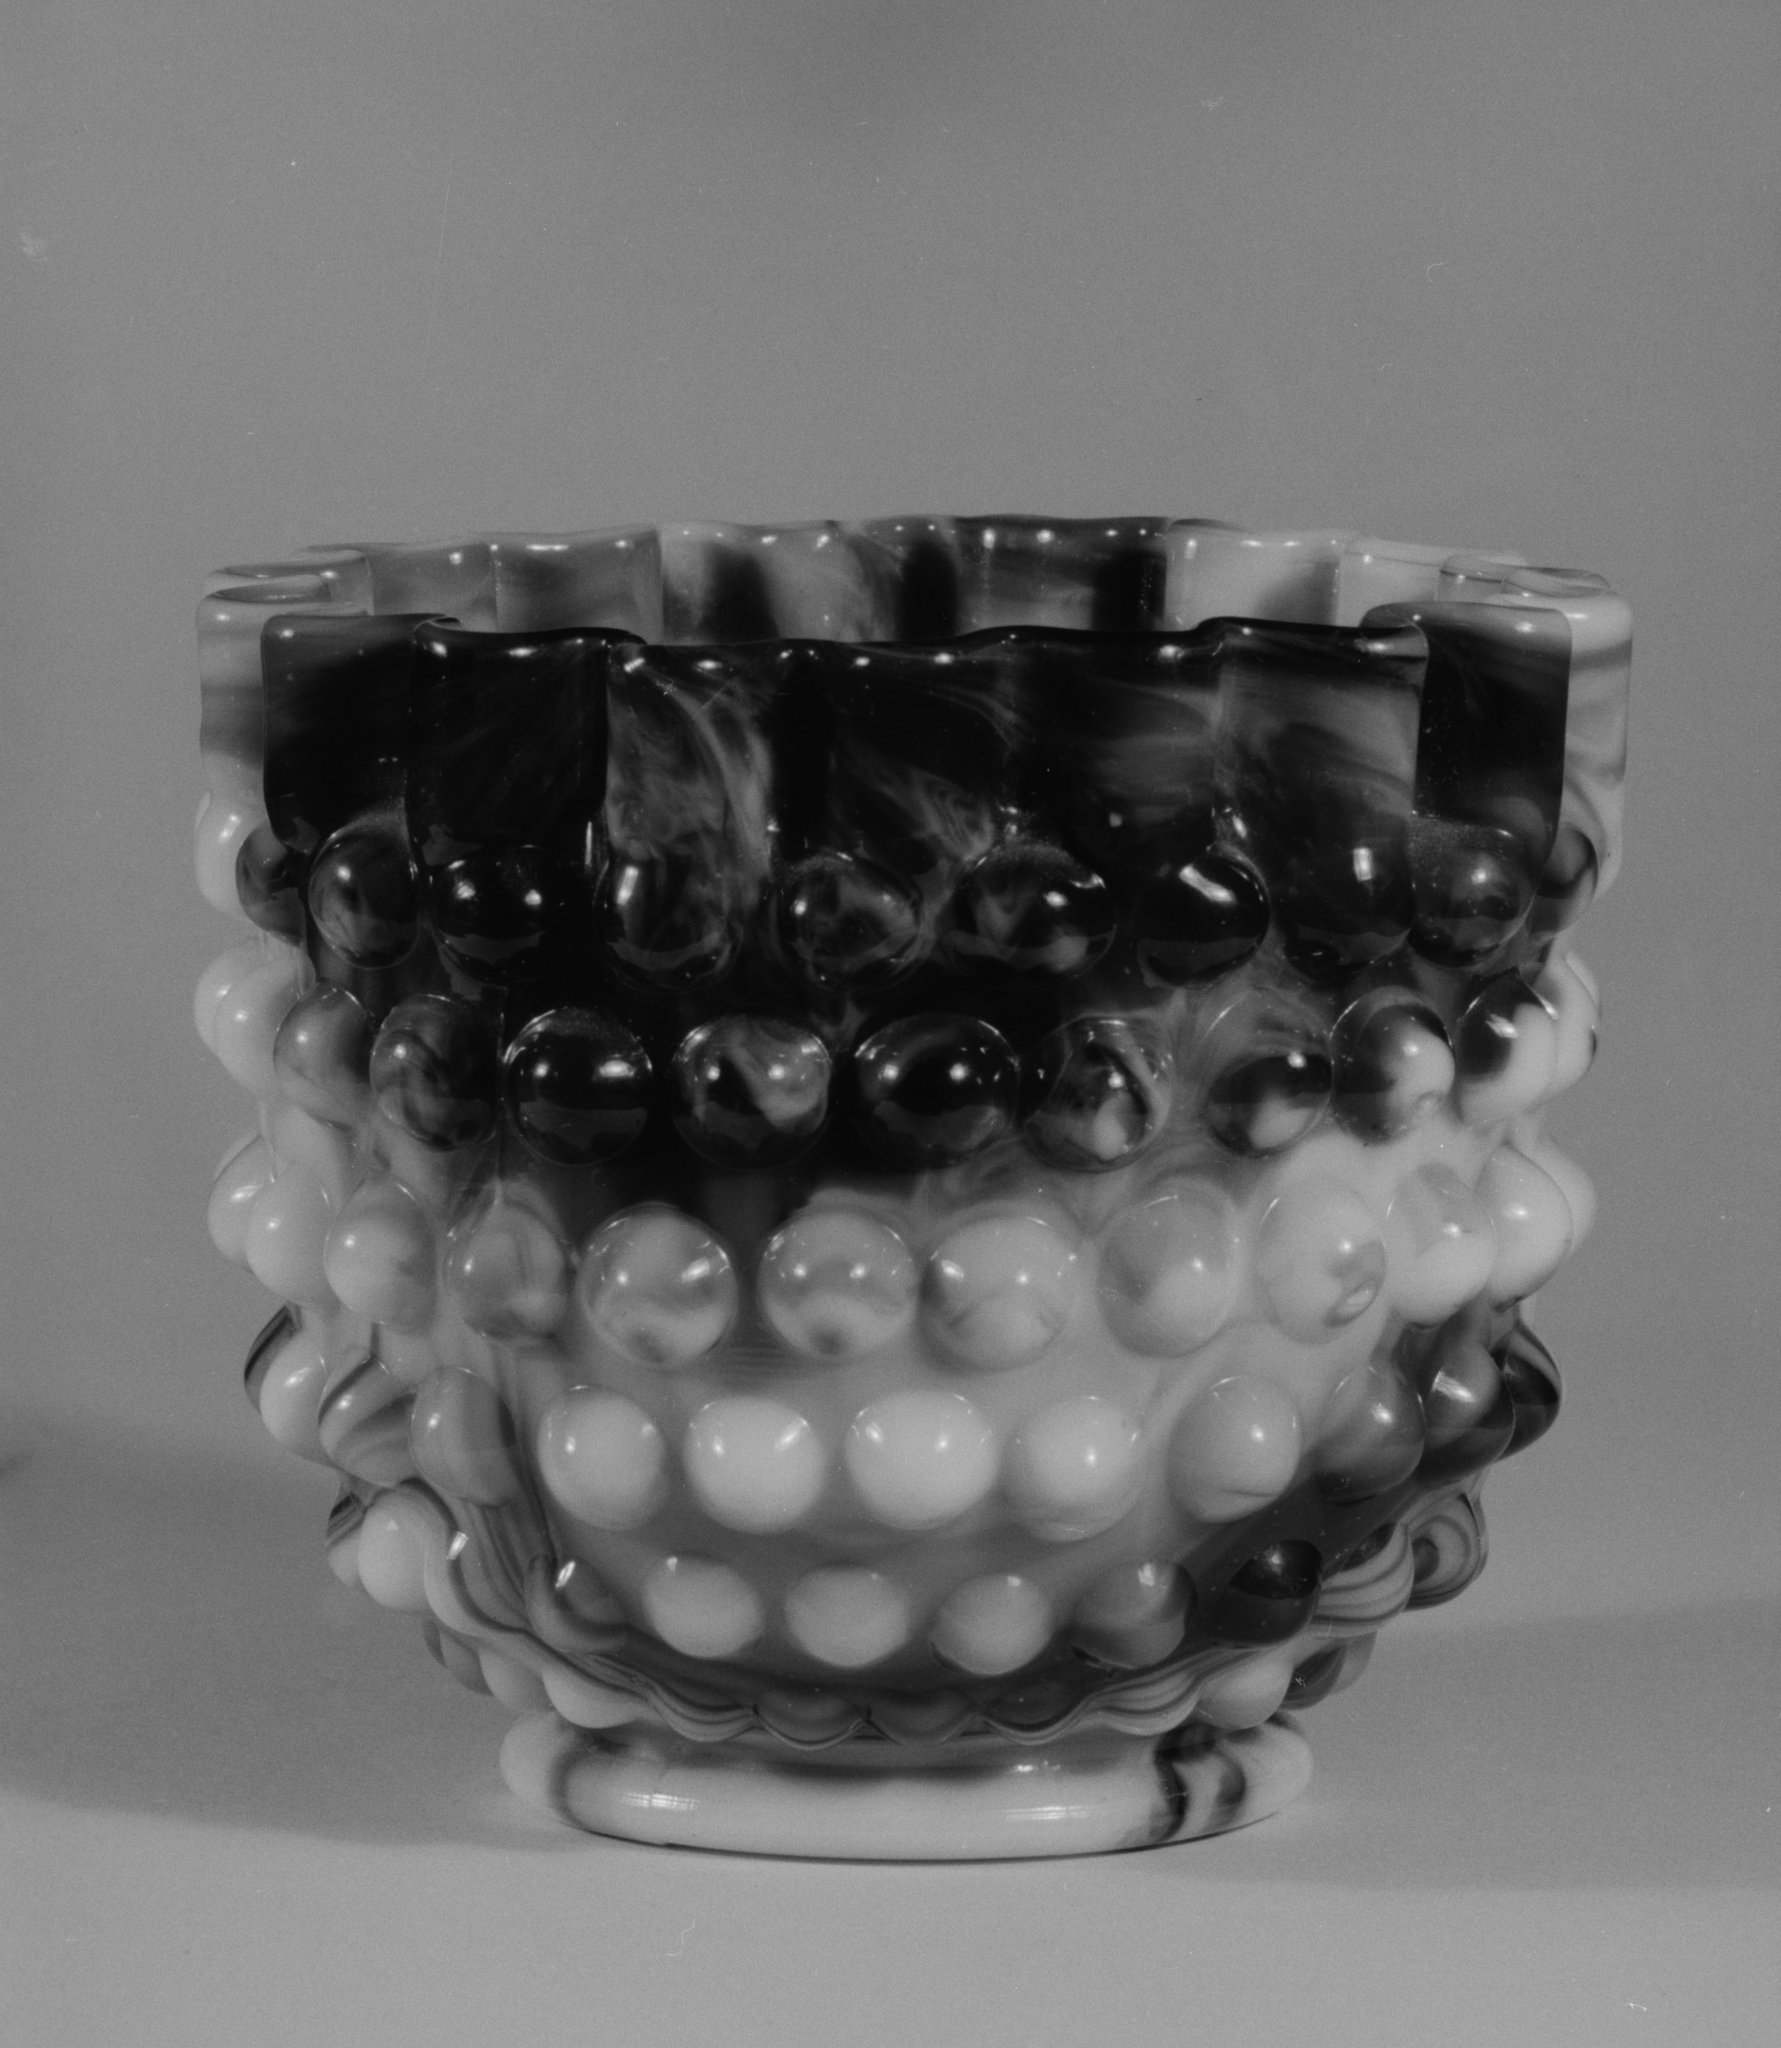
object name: bowl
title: Hobnail Bowl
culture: british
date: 1870-1900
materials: glass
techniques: pressed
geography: england